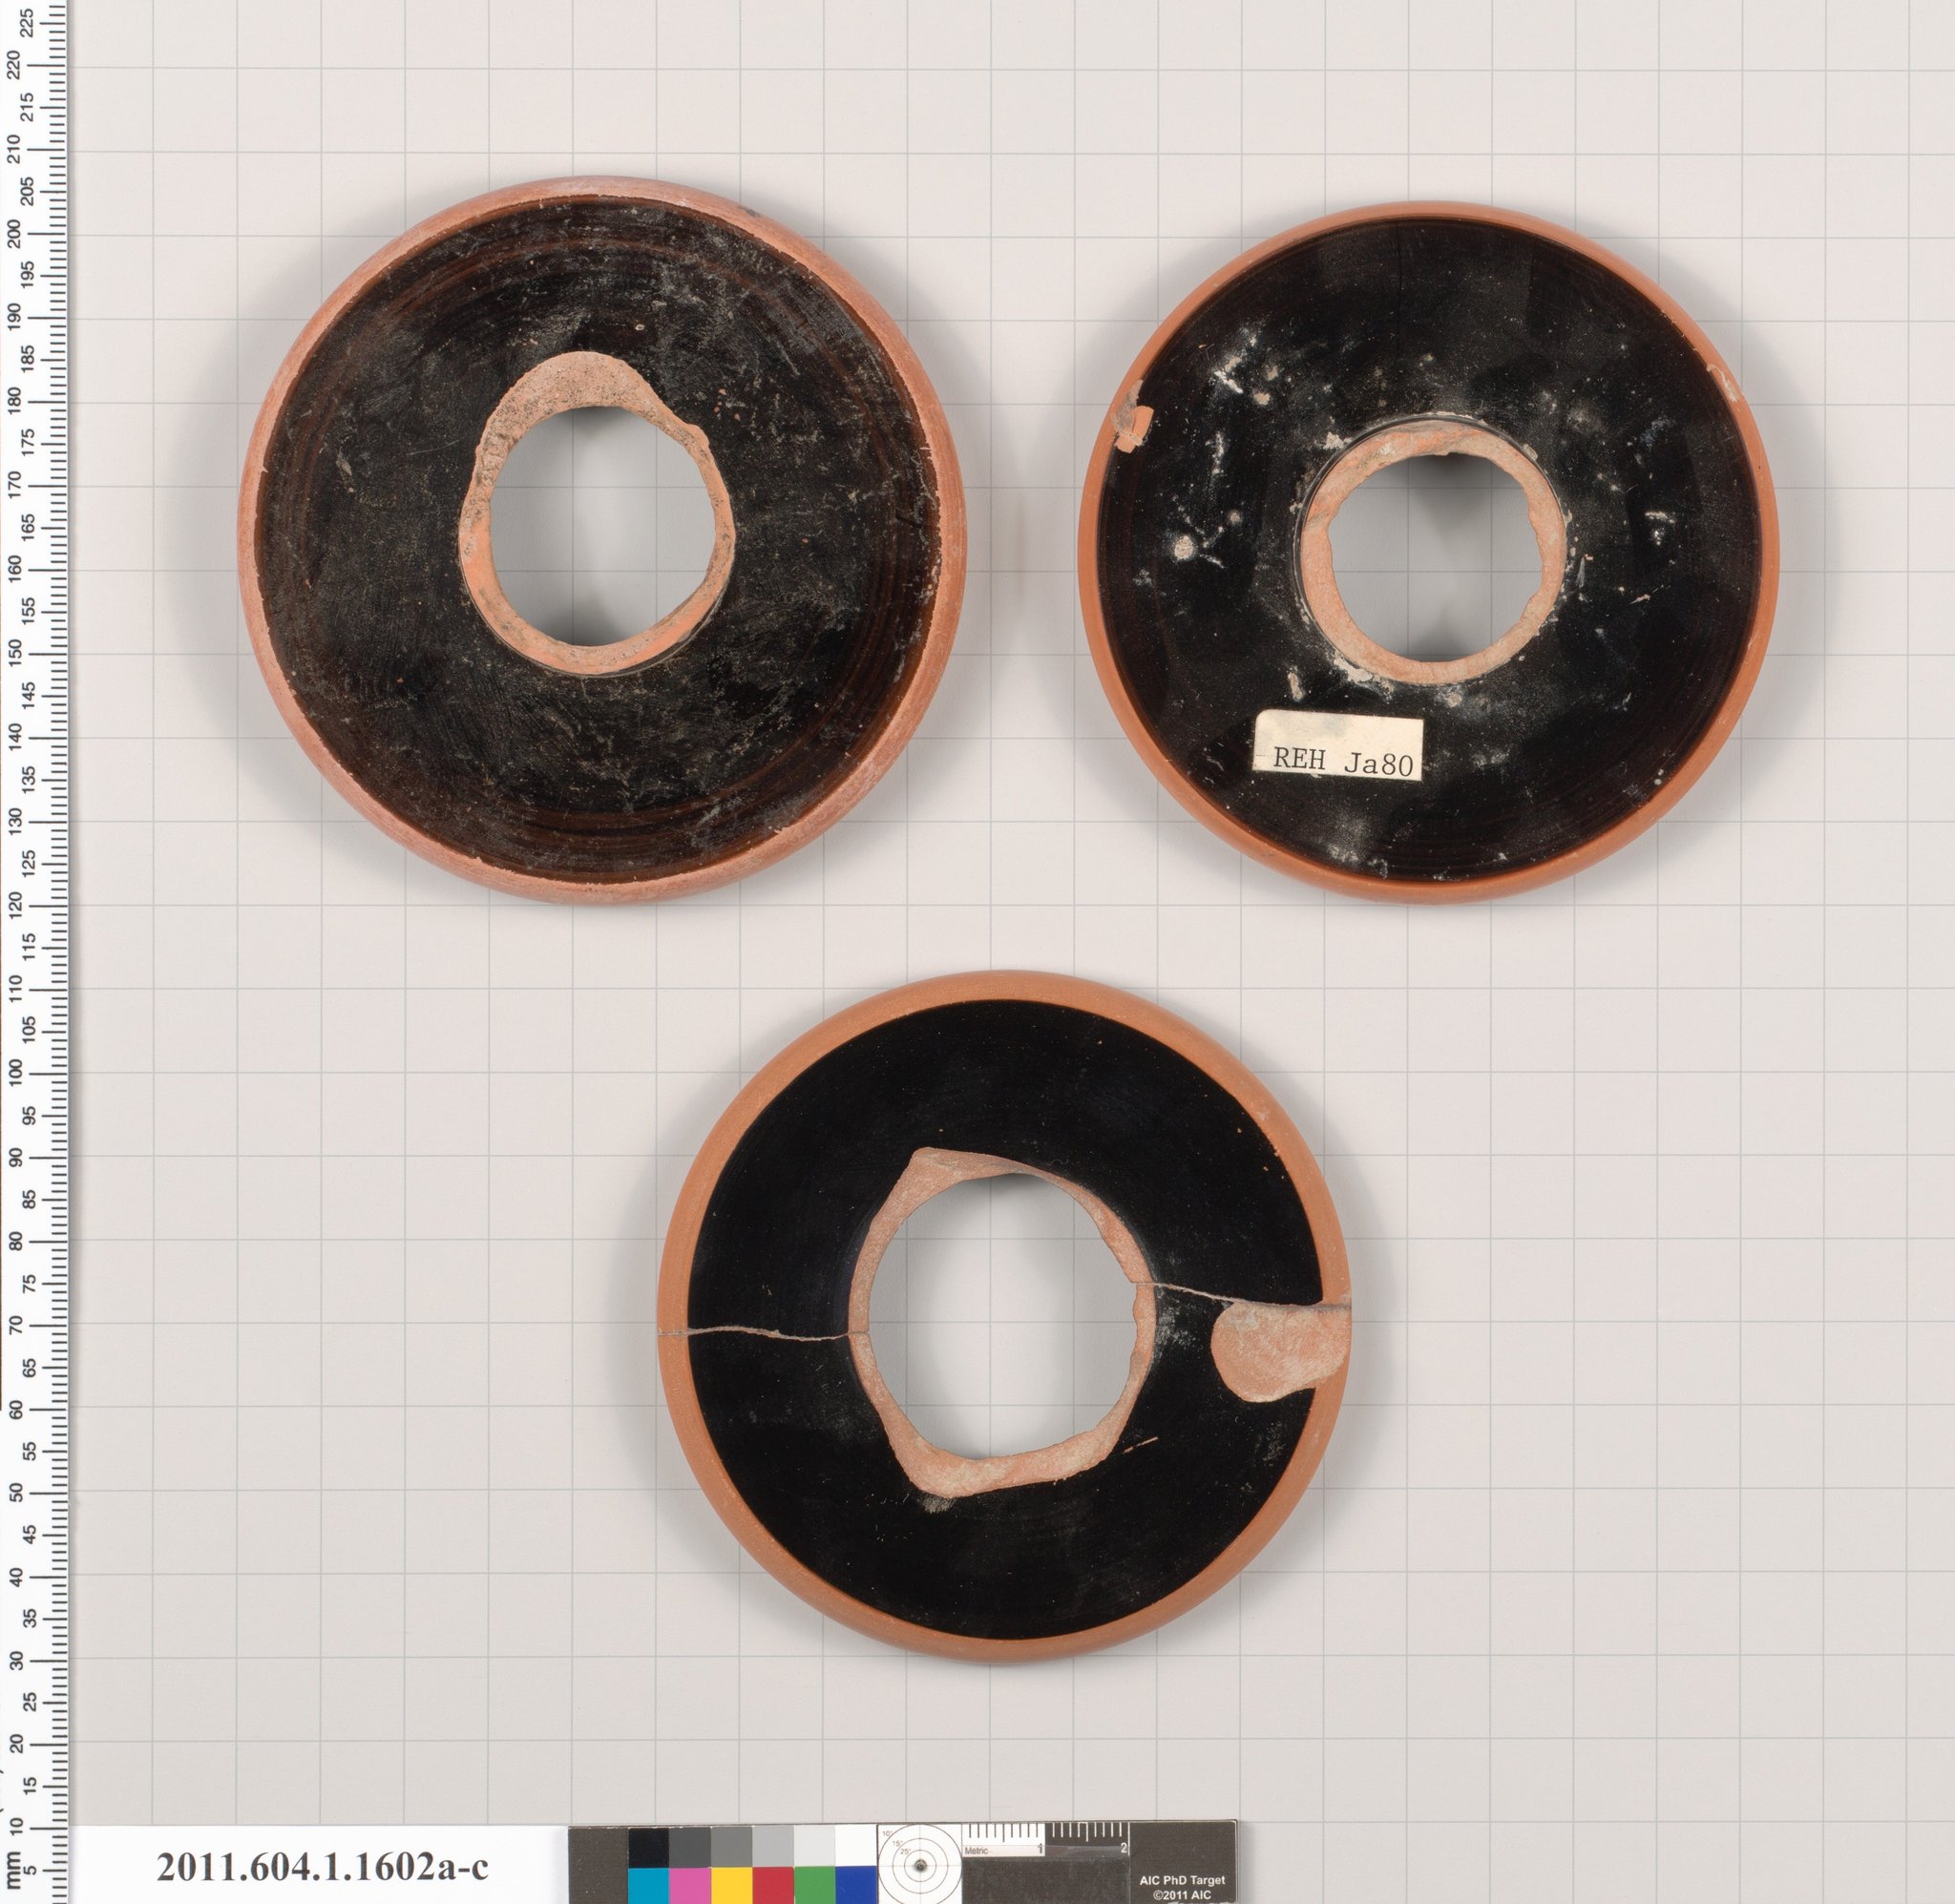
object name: kylix fragment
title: Terracotta fragments of kylikes (drinking cups)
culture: greek, attic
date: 500-401 BCE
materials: terracotta